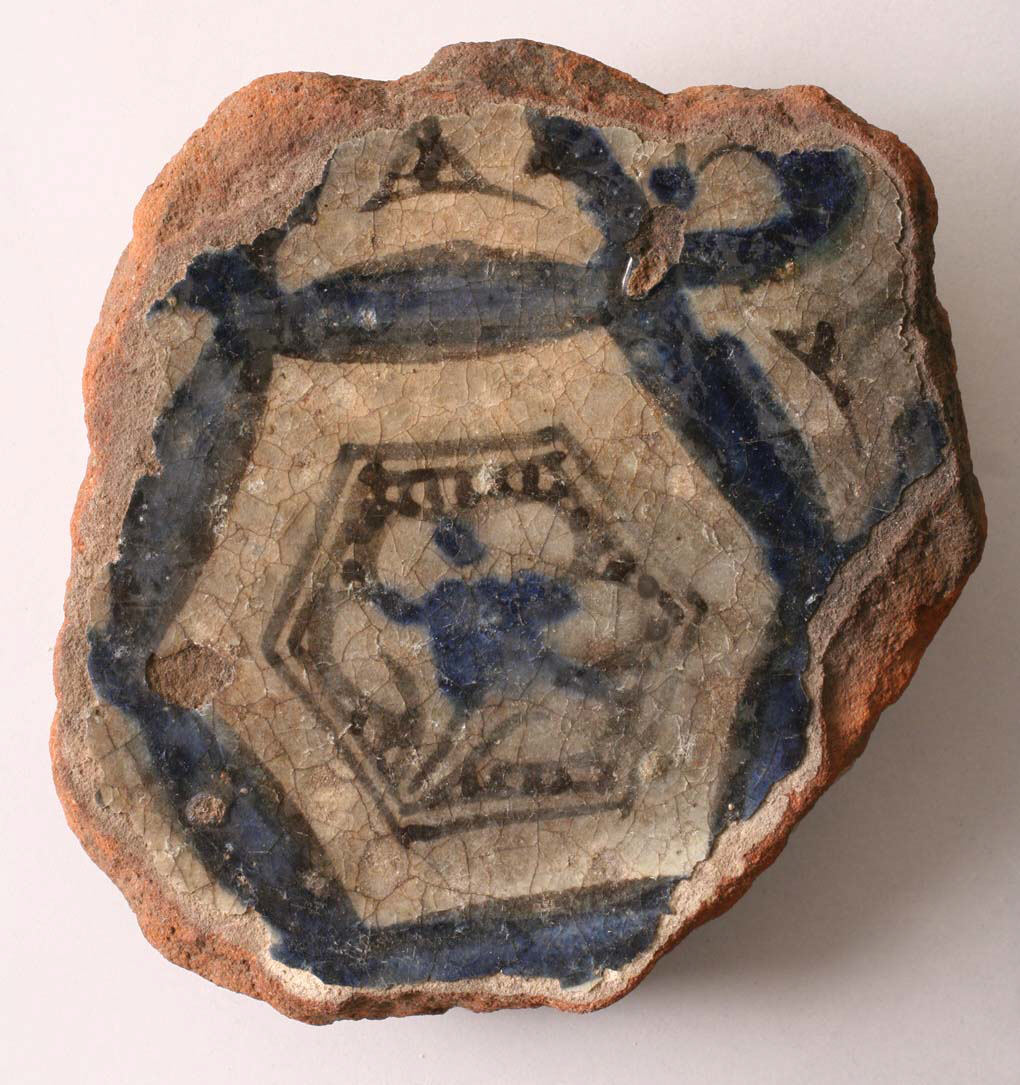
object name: ceramic fragment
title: Fragment of a Bowl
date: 1401-1500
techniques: glazing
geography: egypt